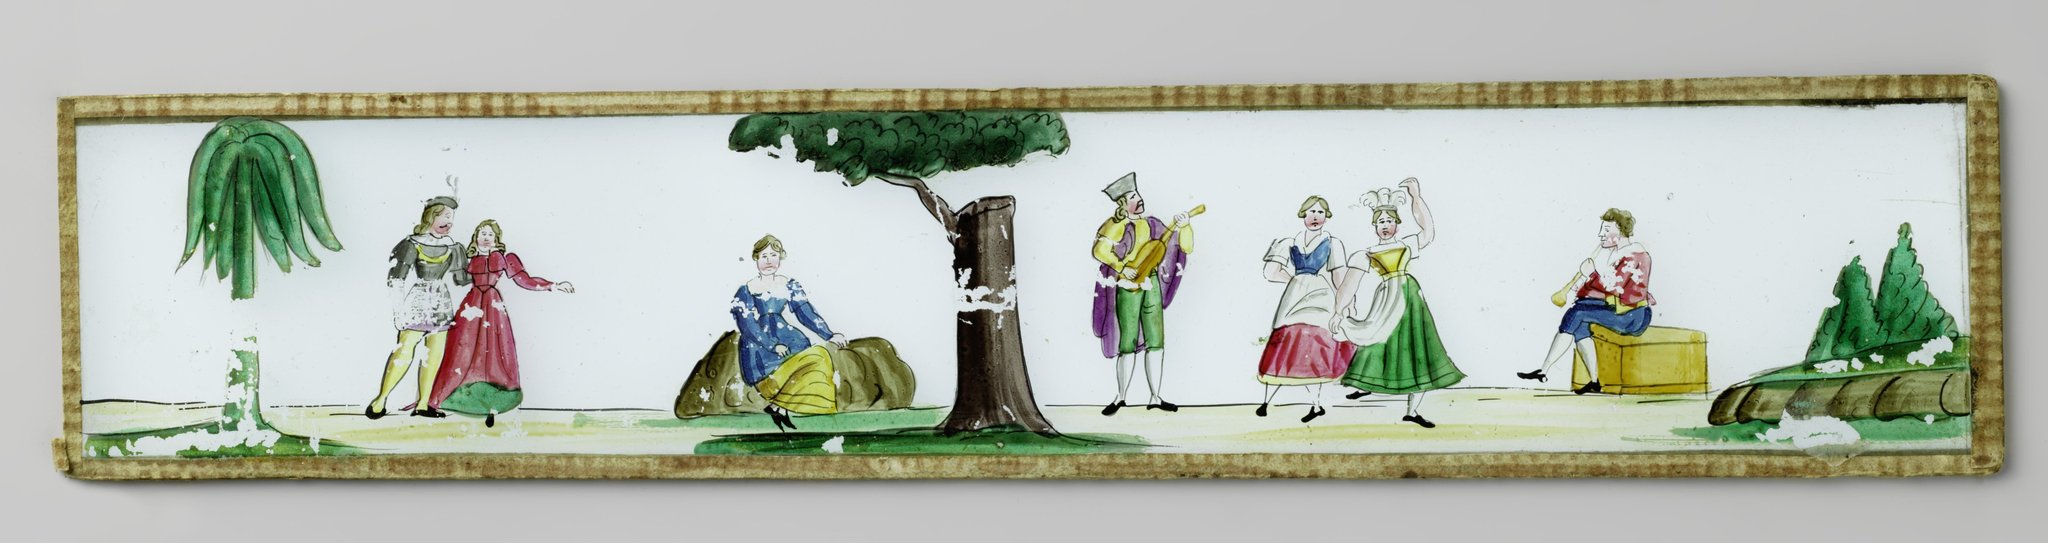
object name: lantern slide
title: Toverlantaarnplaatjes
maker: Anonymous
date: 1800-1900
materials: glass, paint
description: Een toverlantaarnplaat waarop een wandelend paartje, een rustende vrouw en twee muzikanten met dansende vrouwen staan afgebeeld.